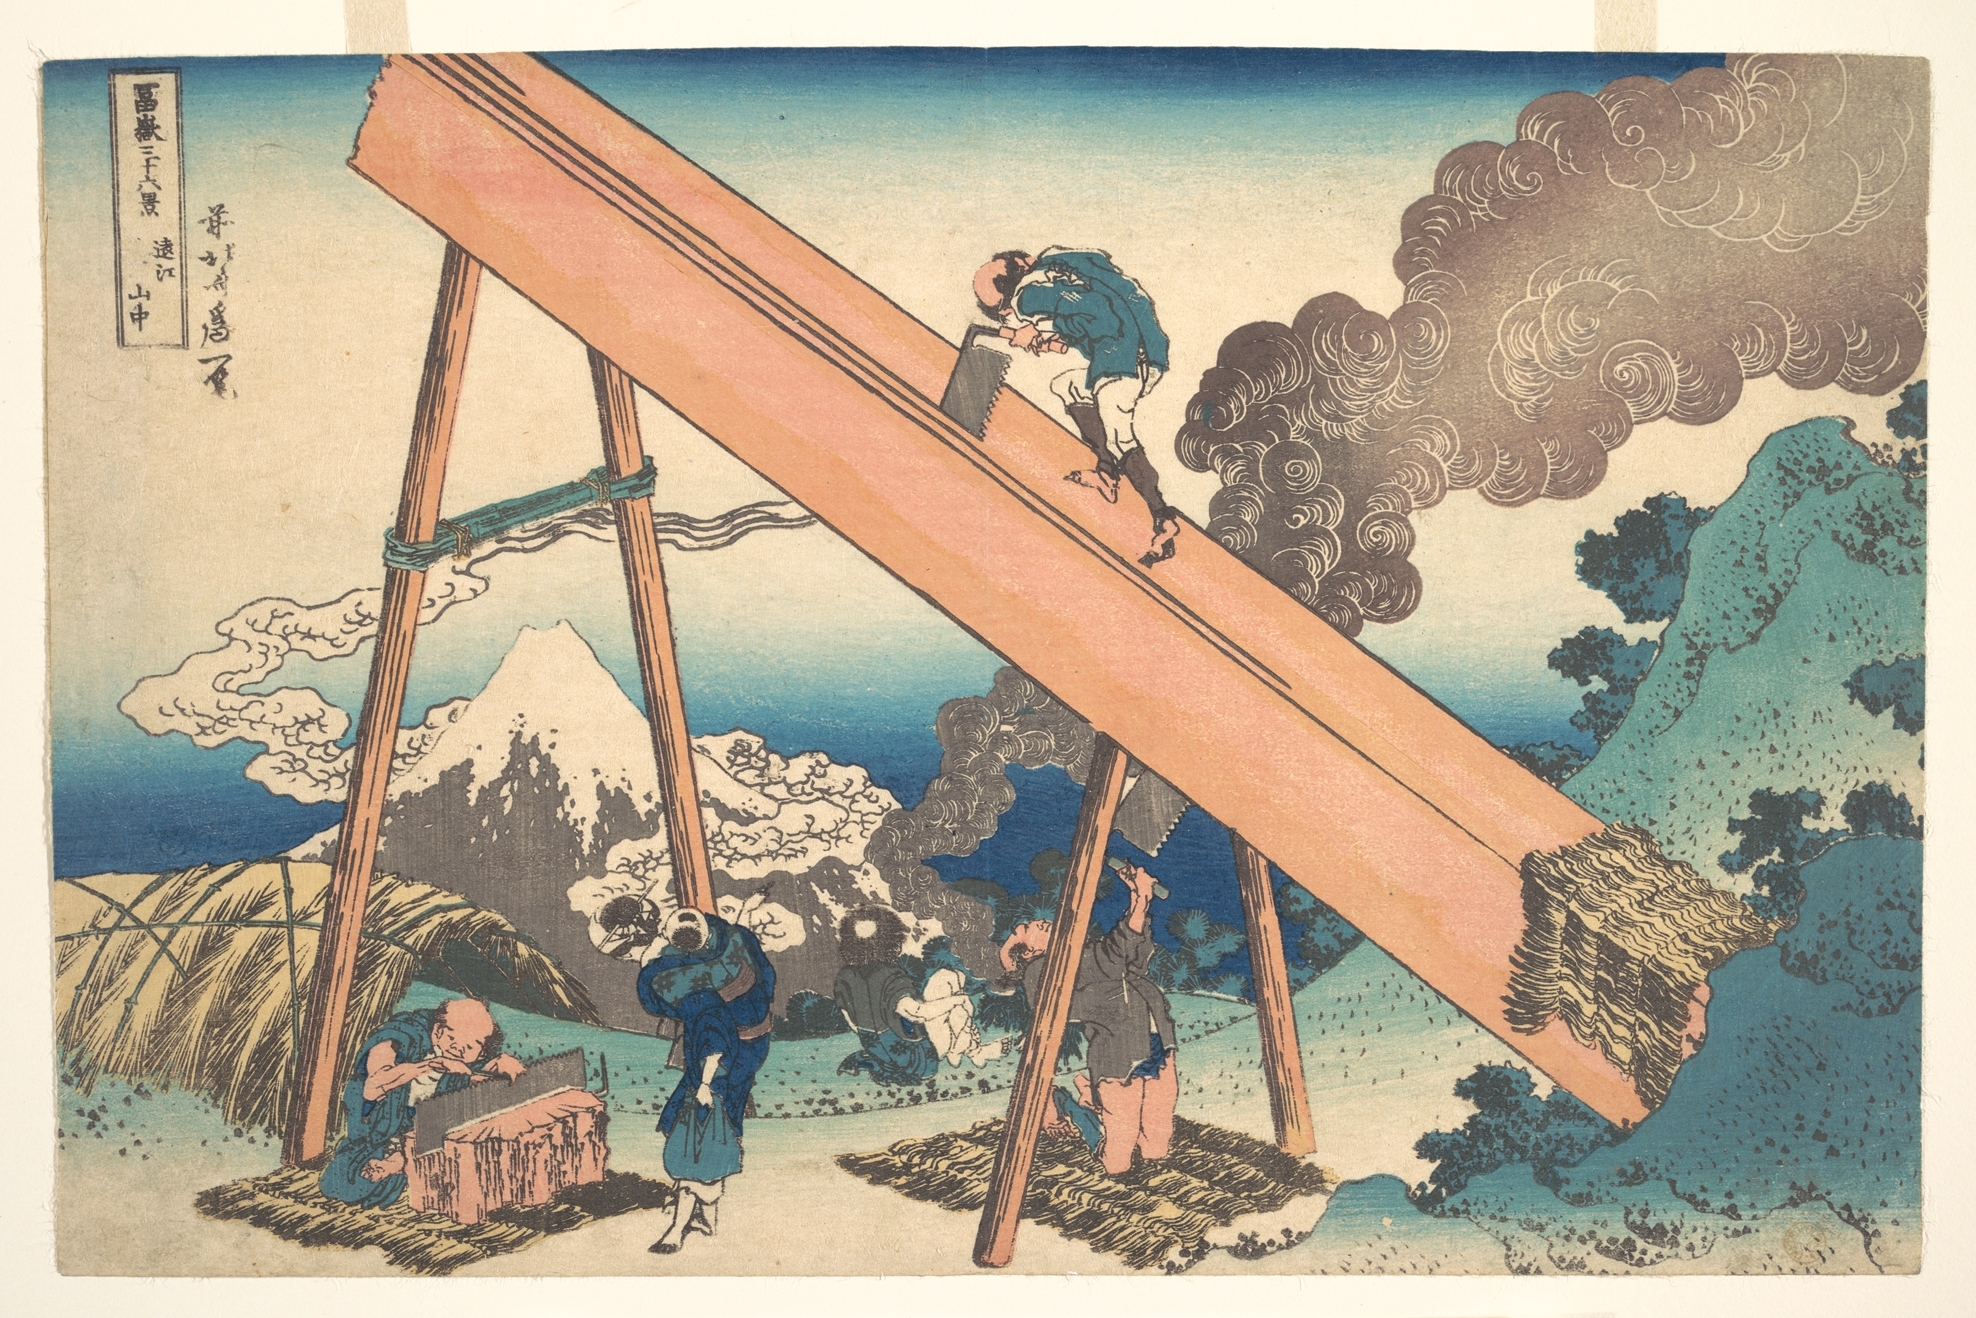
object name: woodblock print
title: In the Mountains of Tōtomi Province (Tōtomi sanchū), from the series Thirty-six Views of Mount Fuji (Fugaku sanjūrokkei)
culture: japanese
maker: katsushika hokusai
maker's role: artist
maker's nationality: japanese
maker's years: 1760-1849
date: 1830-1832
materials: ink, paper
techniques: woodblock print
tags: men,mountains,working